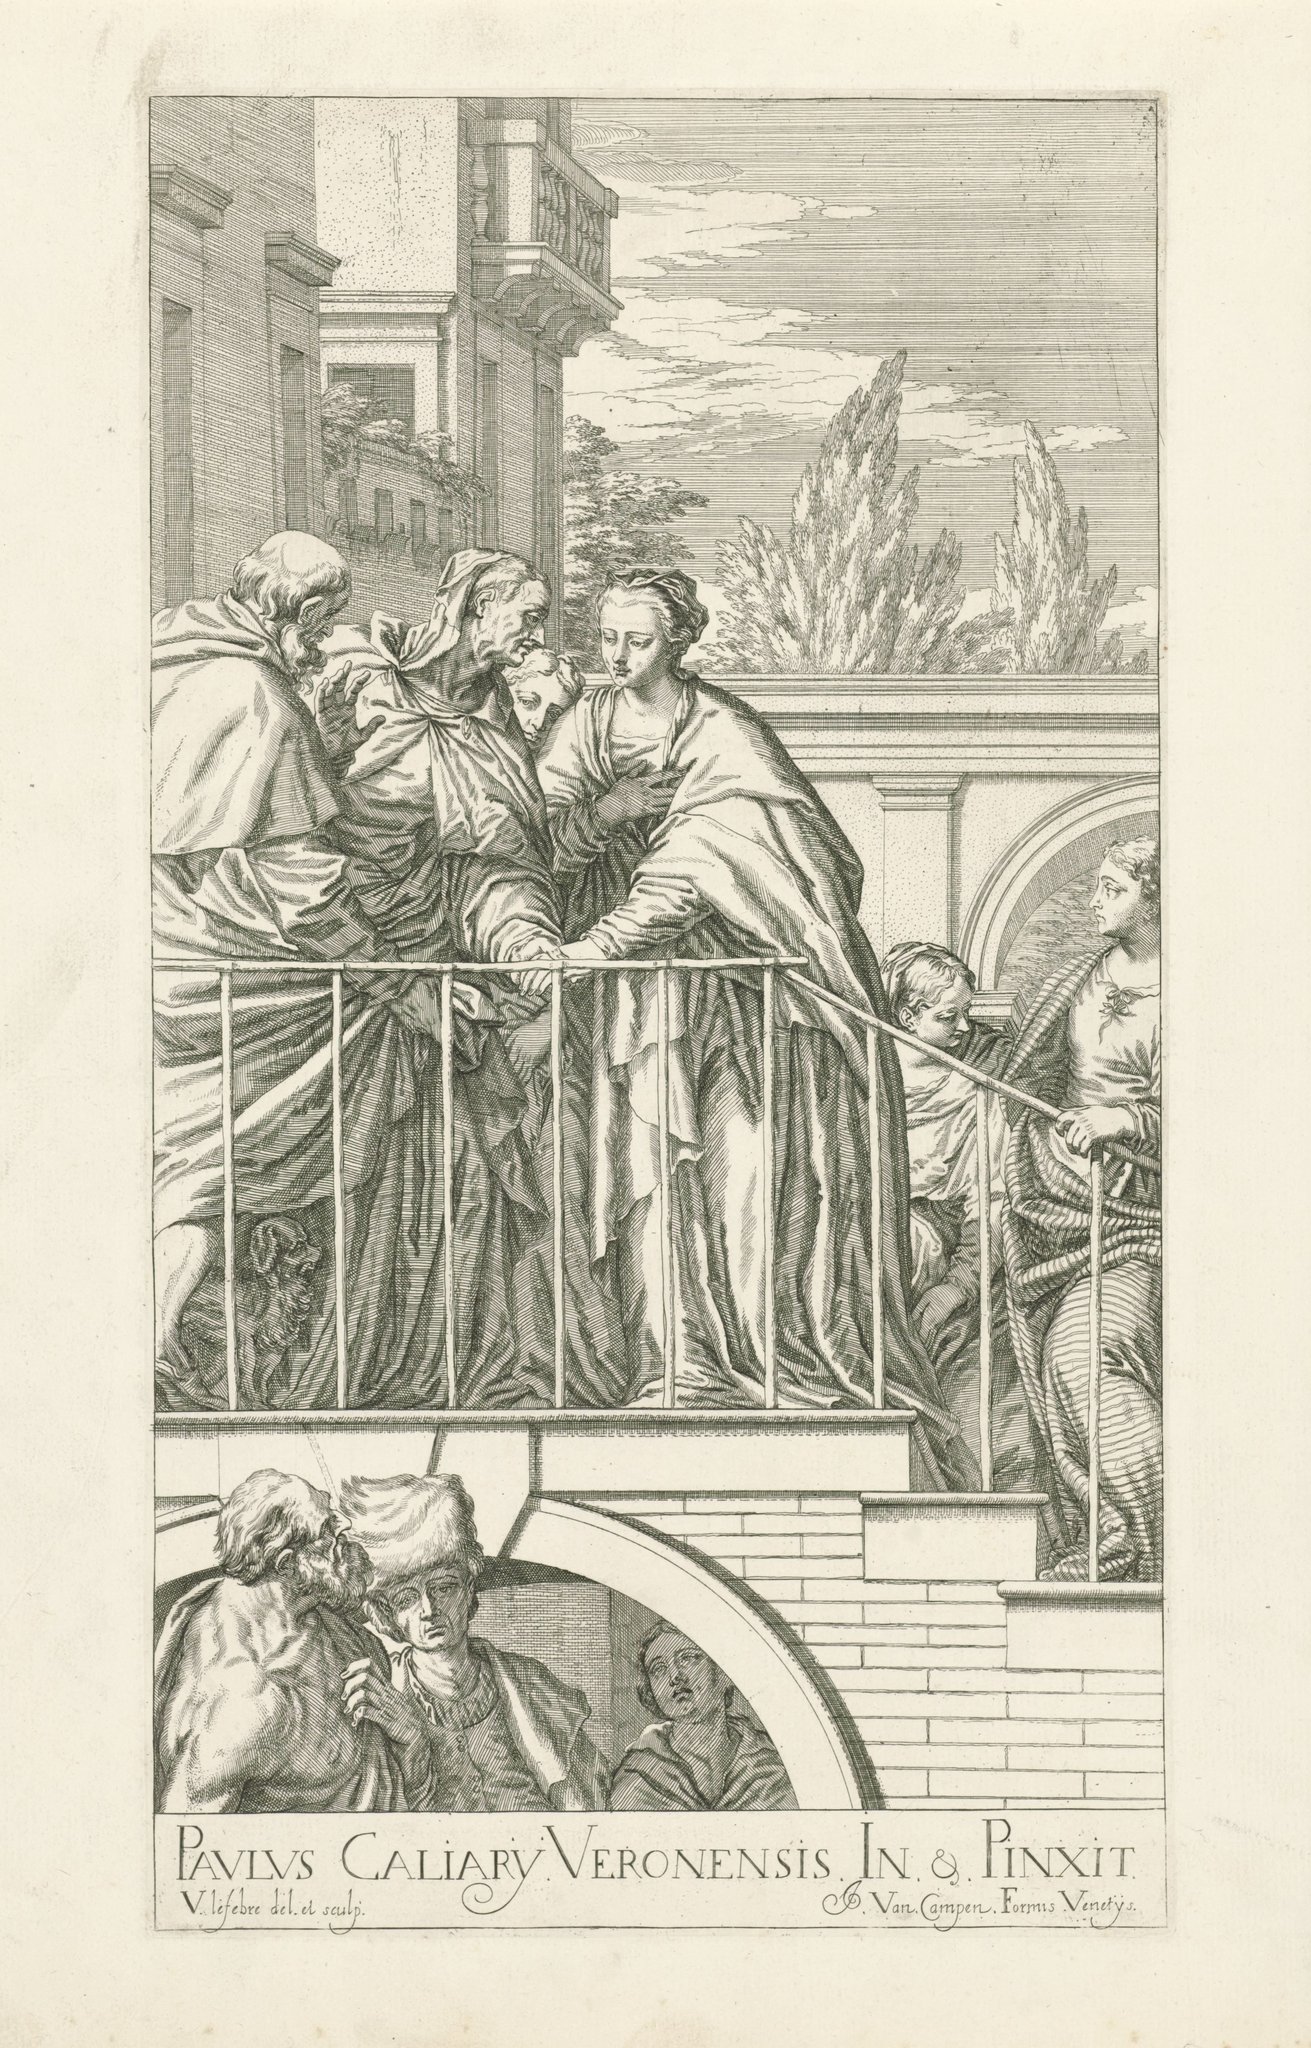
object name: print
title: Opera Selectiora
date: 1682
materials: paper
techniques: etching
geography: venice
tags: mary and elisabeth shaking hands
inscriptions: collector's mark: Lugt 11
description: Maria en Elisabet, beiden net zwanger, ontmoeten elkaar op een trap bij een stadspoort. De prent maakt deel uit van een 53-delige serie prenten naar schilderijen van Titiaan en Veronese.